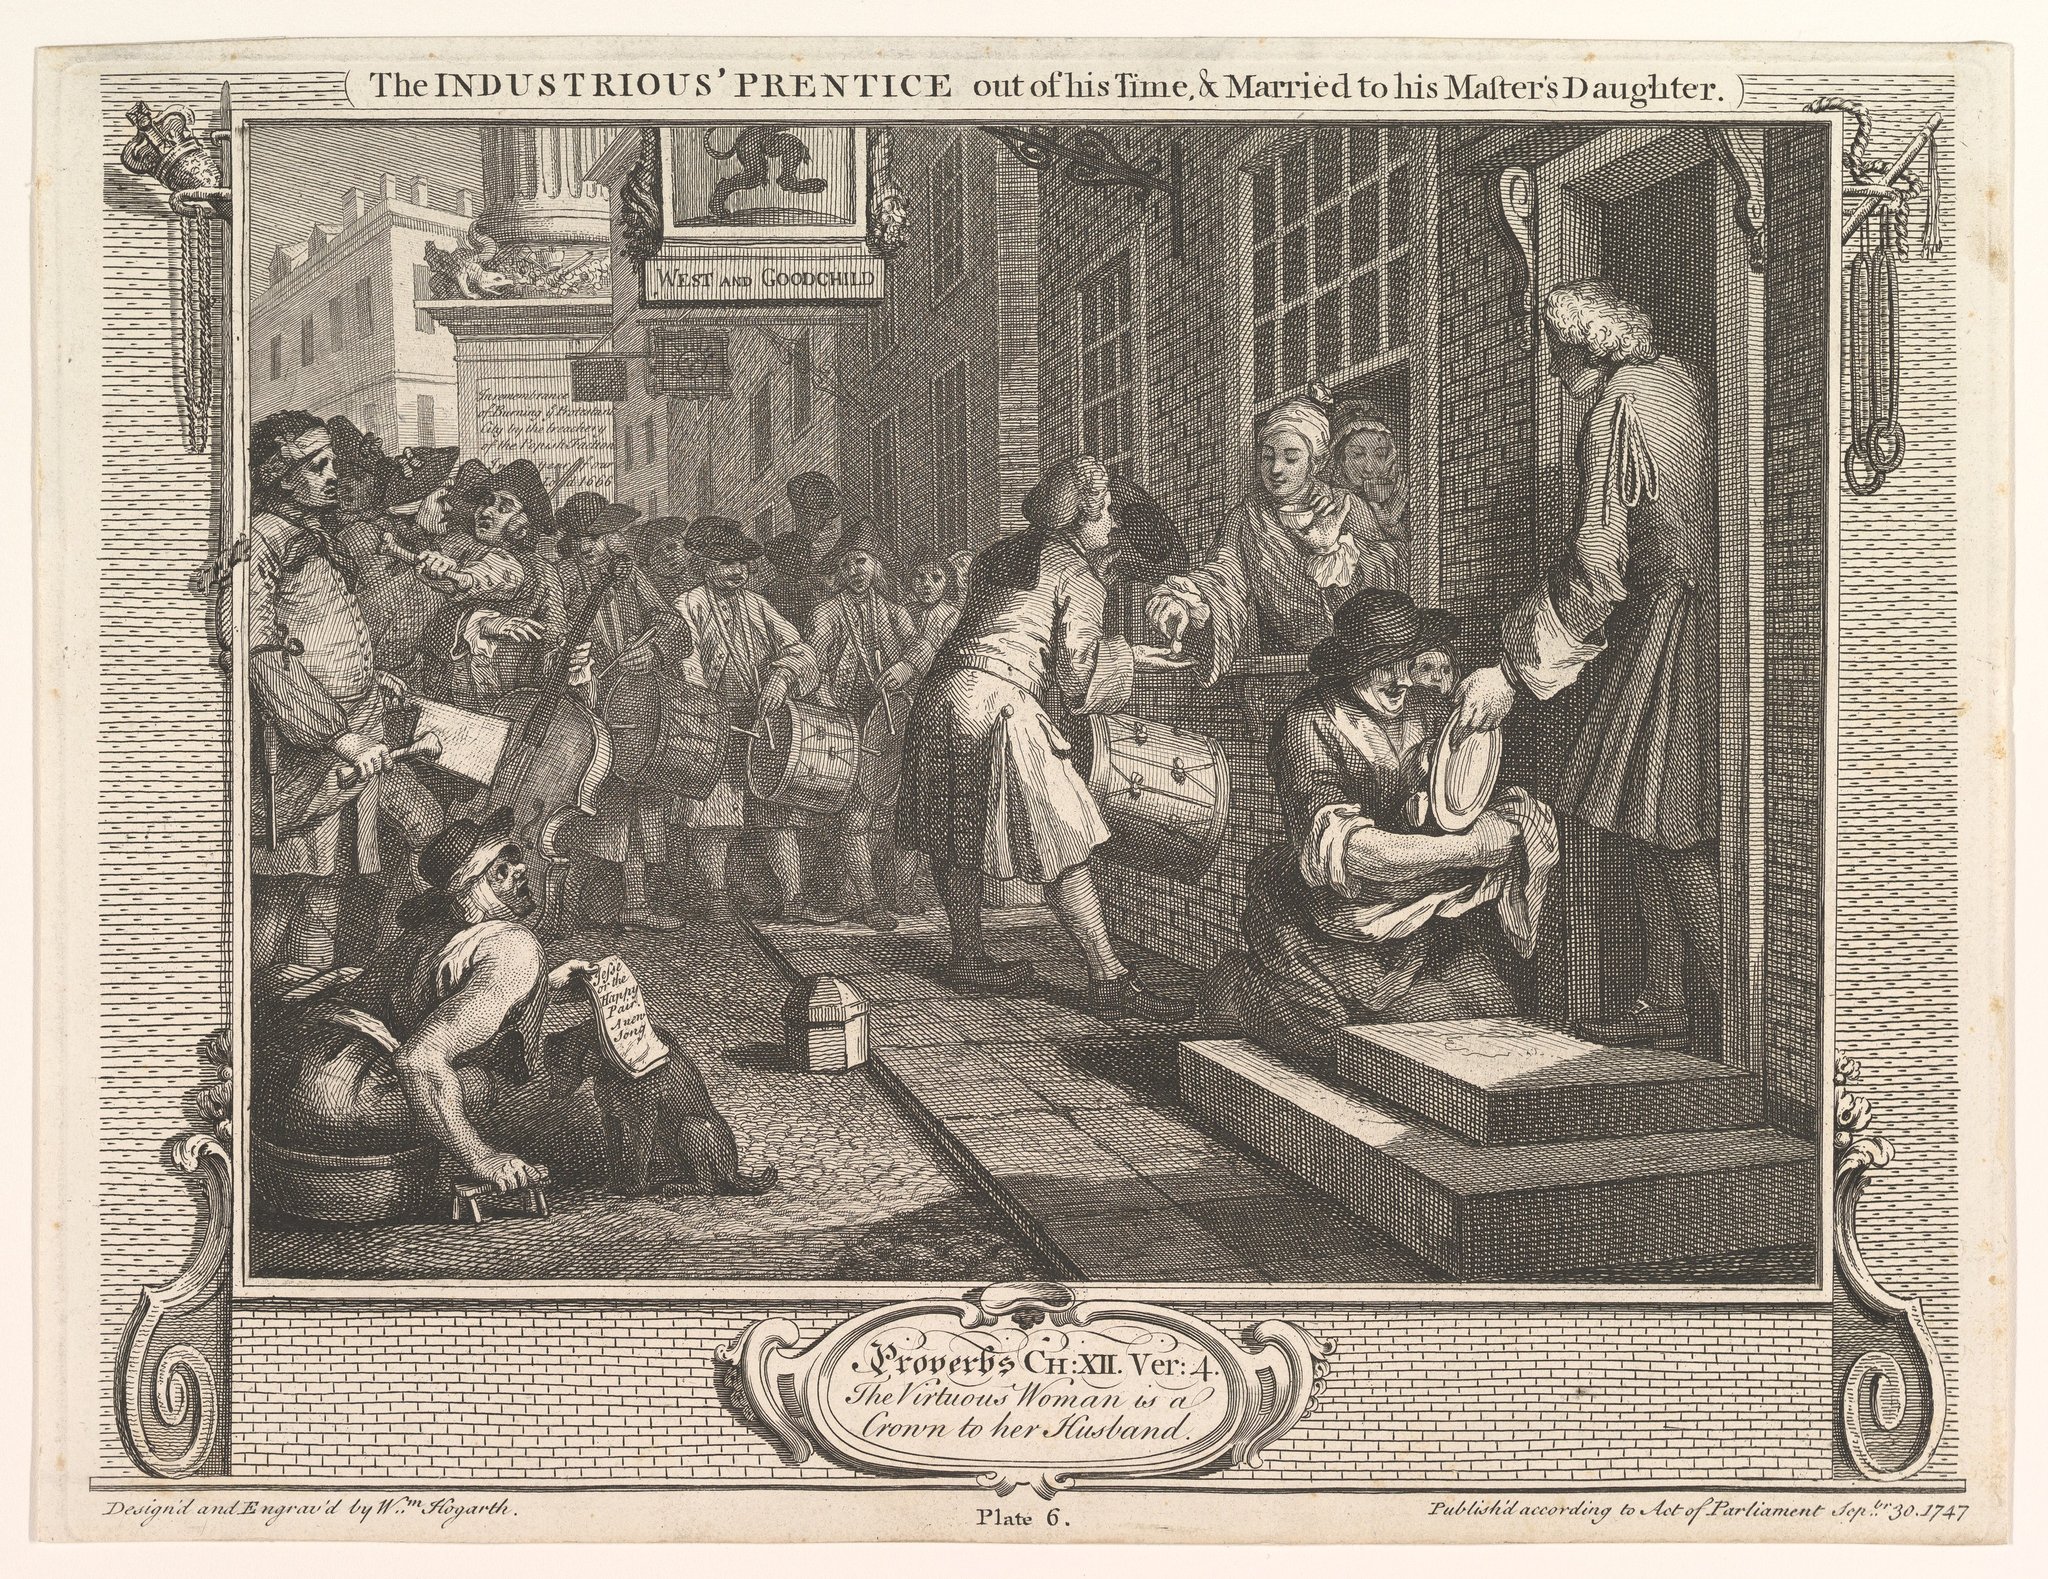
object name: print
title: The Industrious 'Prentice Out of his Time and Married to his Master's Daughter (Industry and Idleness, plate 6)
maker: william hogarth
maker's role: artist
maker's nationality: british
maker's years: 1697-1764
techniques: engraving, etching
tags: buildings,men,women,drums